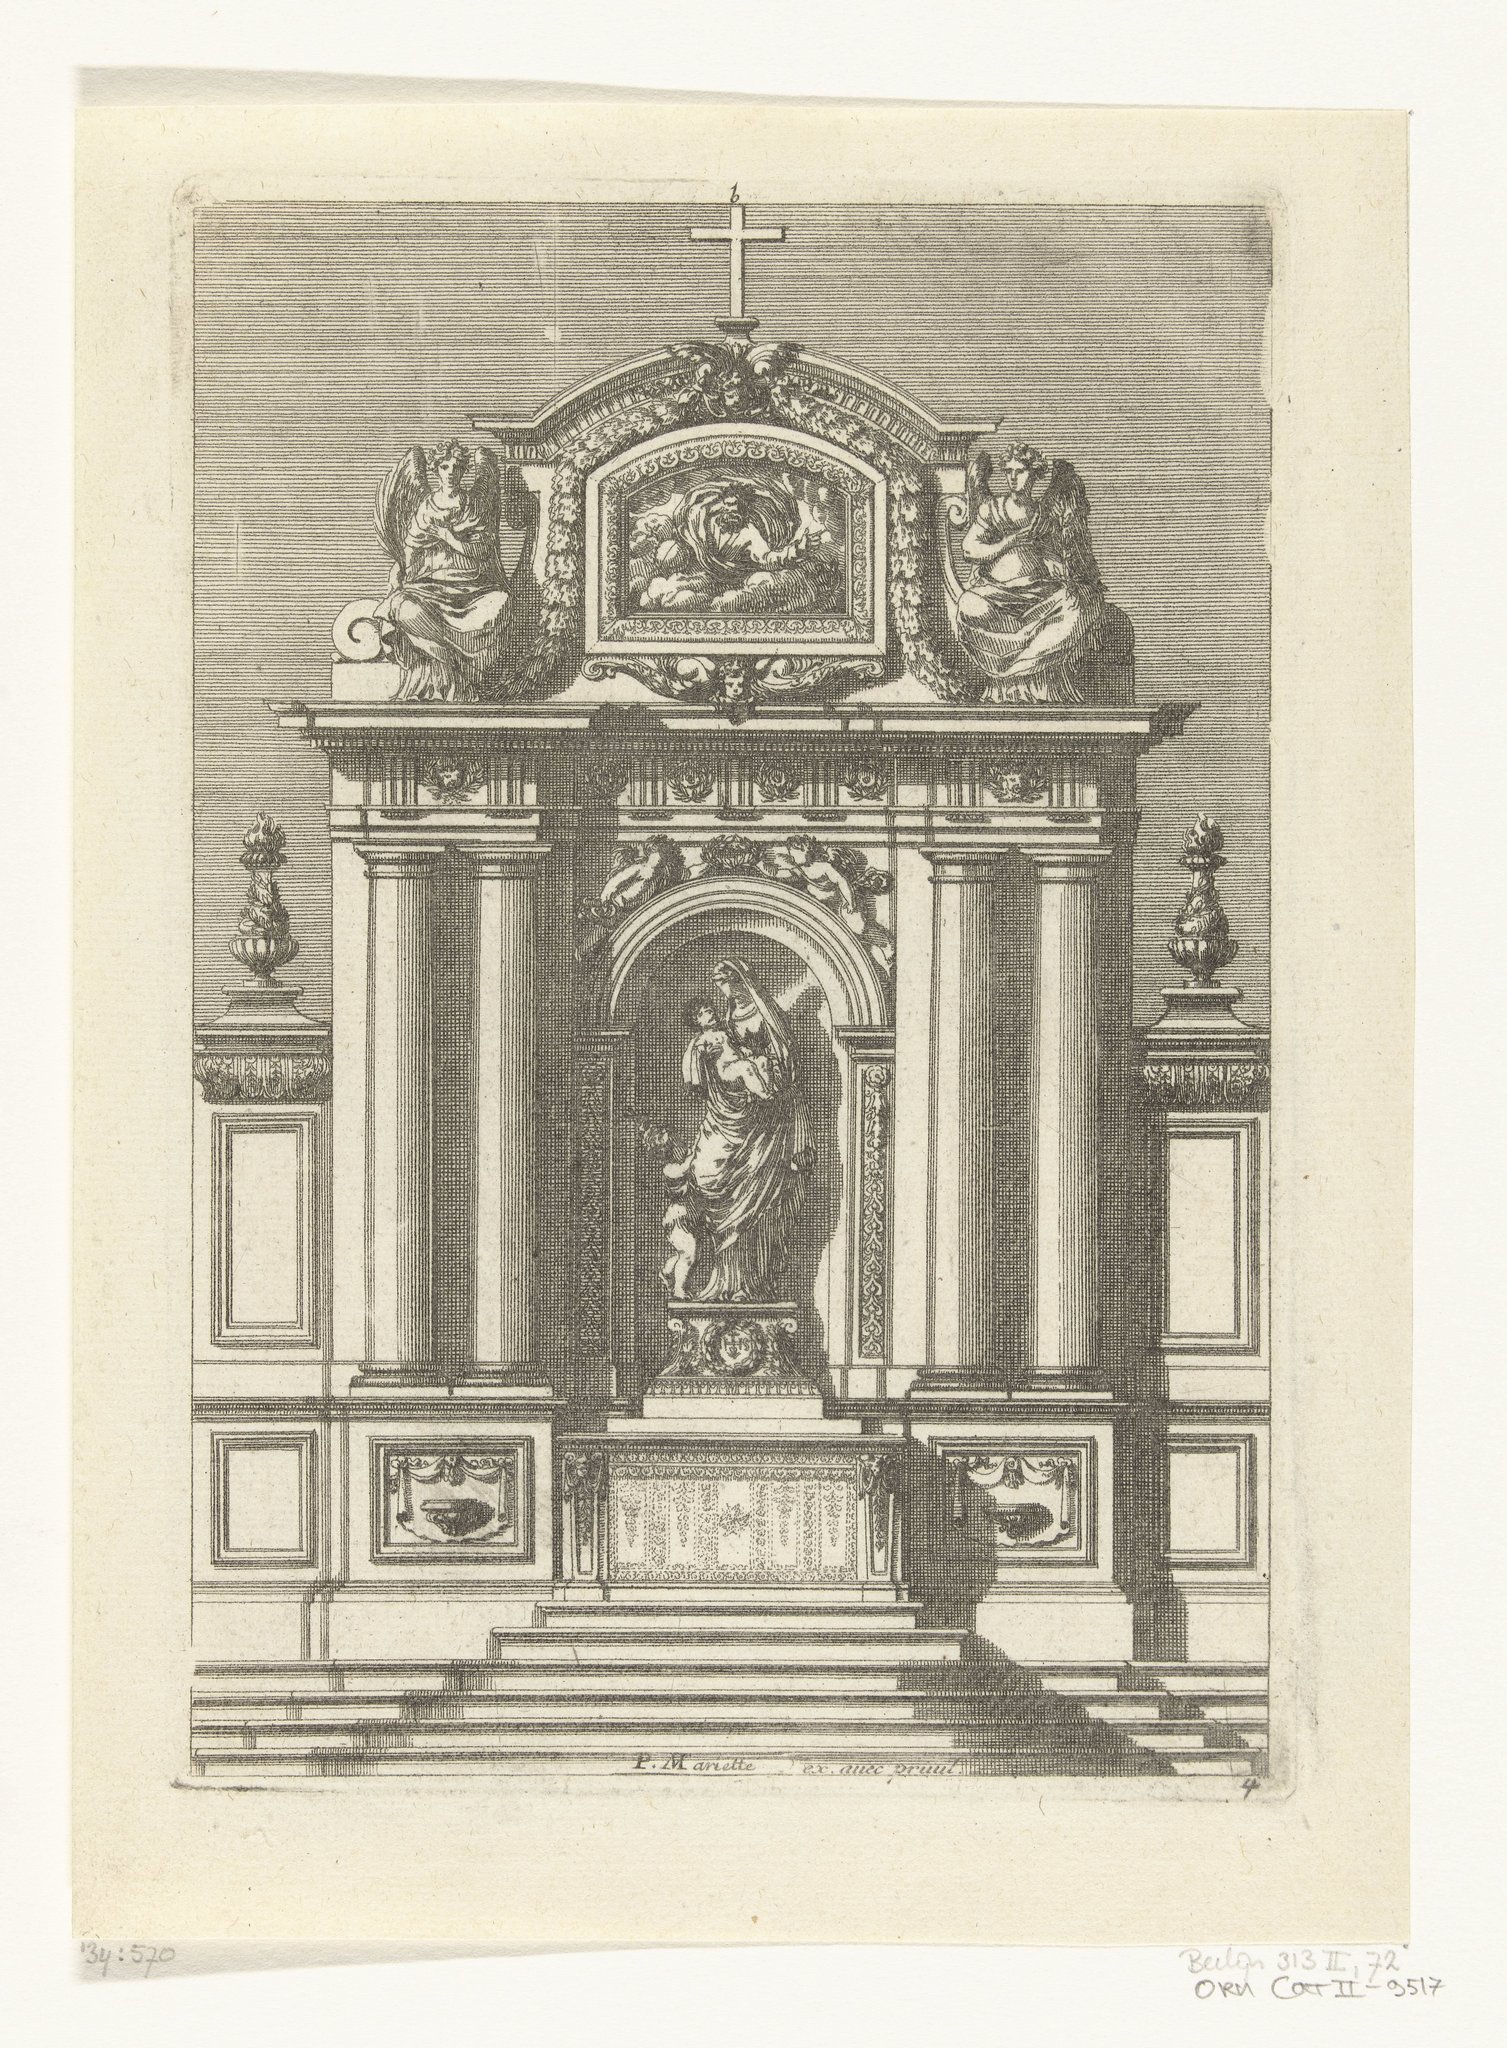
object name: print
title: Authels et Retables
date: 1666-1693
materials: paper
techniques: etching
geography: france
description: Op het altaar staat een standbeeld van de Heilige Maagd met het Kind Christus, bovenaan hangt een paneel met God de Vader. Midden boven staat de letter b. Uit tweede editie van serie met altaren en tabernakels.